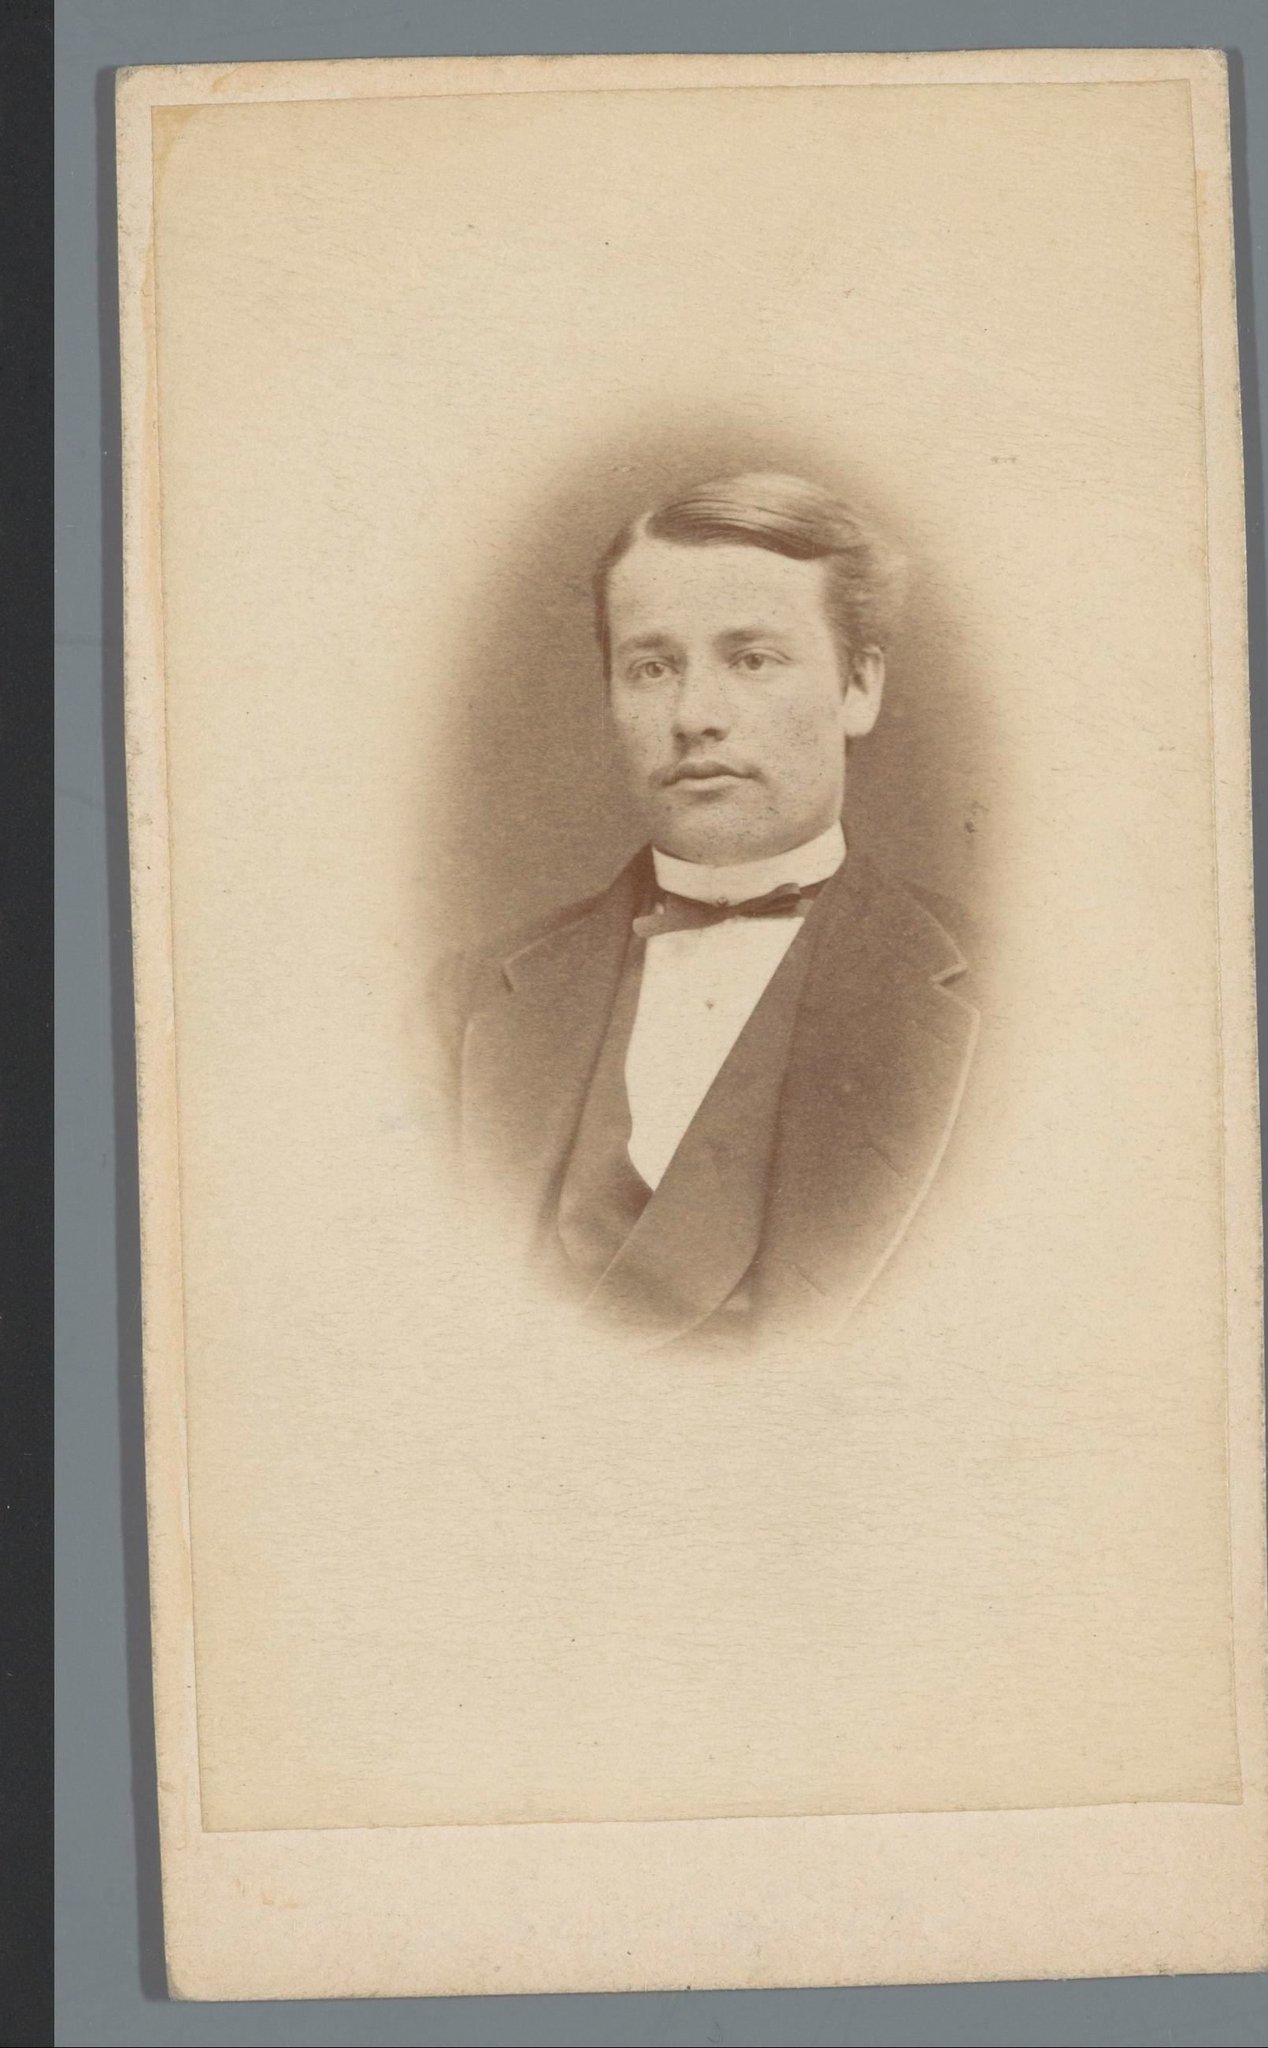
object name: photograph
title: Portret van een onbekende jonge man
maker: anders anderzon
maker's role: fotograaf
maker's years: 1834-1916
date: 1860-1880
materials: cardboard, paper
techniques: albumen print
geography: strängnäs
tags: youth, adolescent, anonymous historical person portrayed